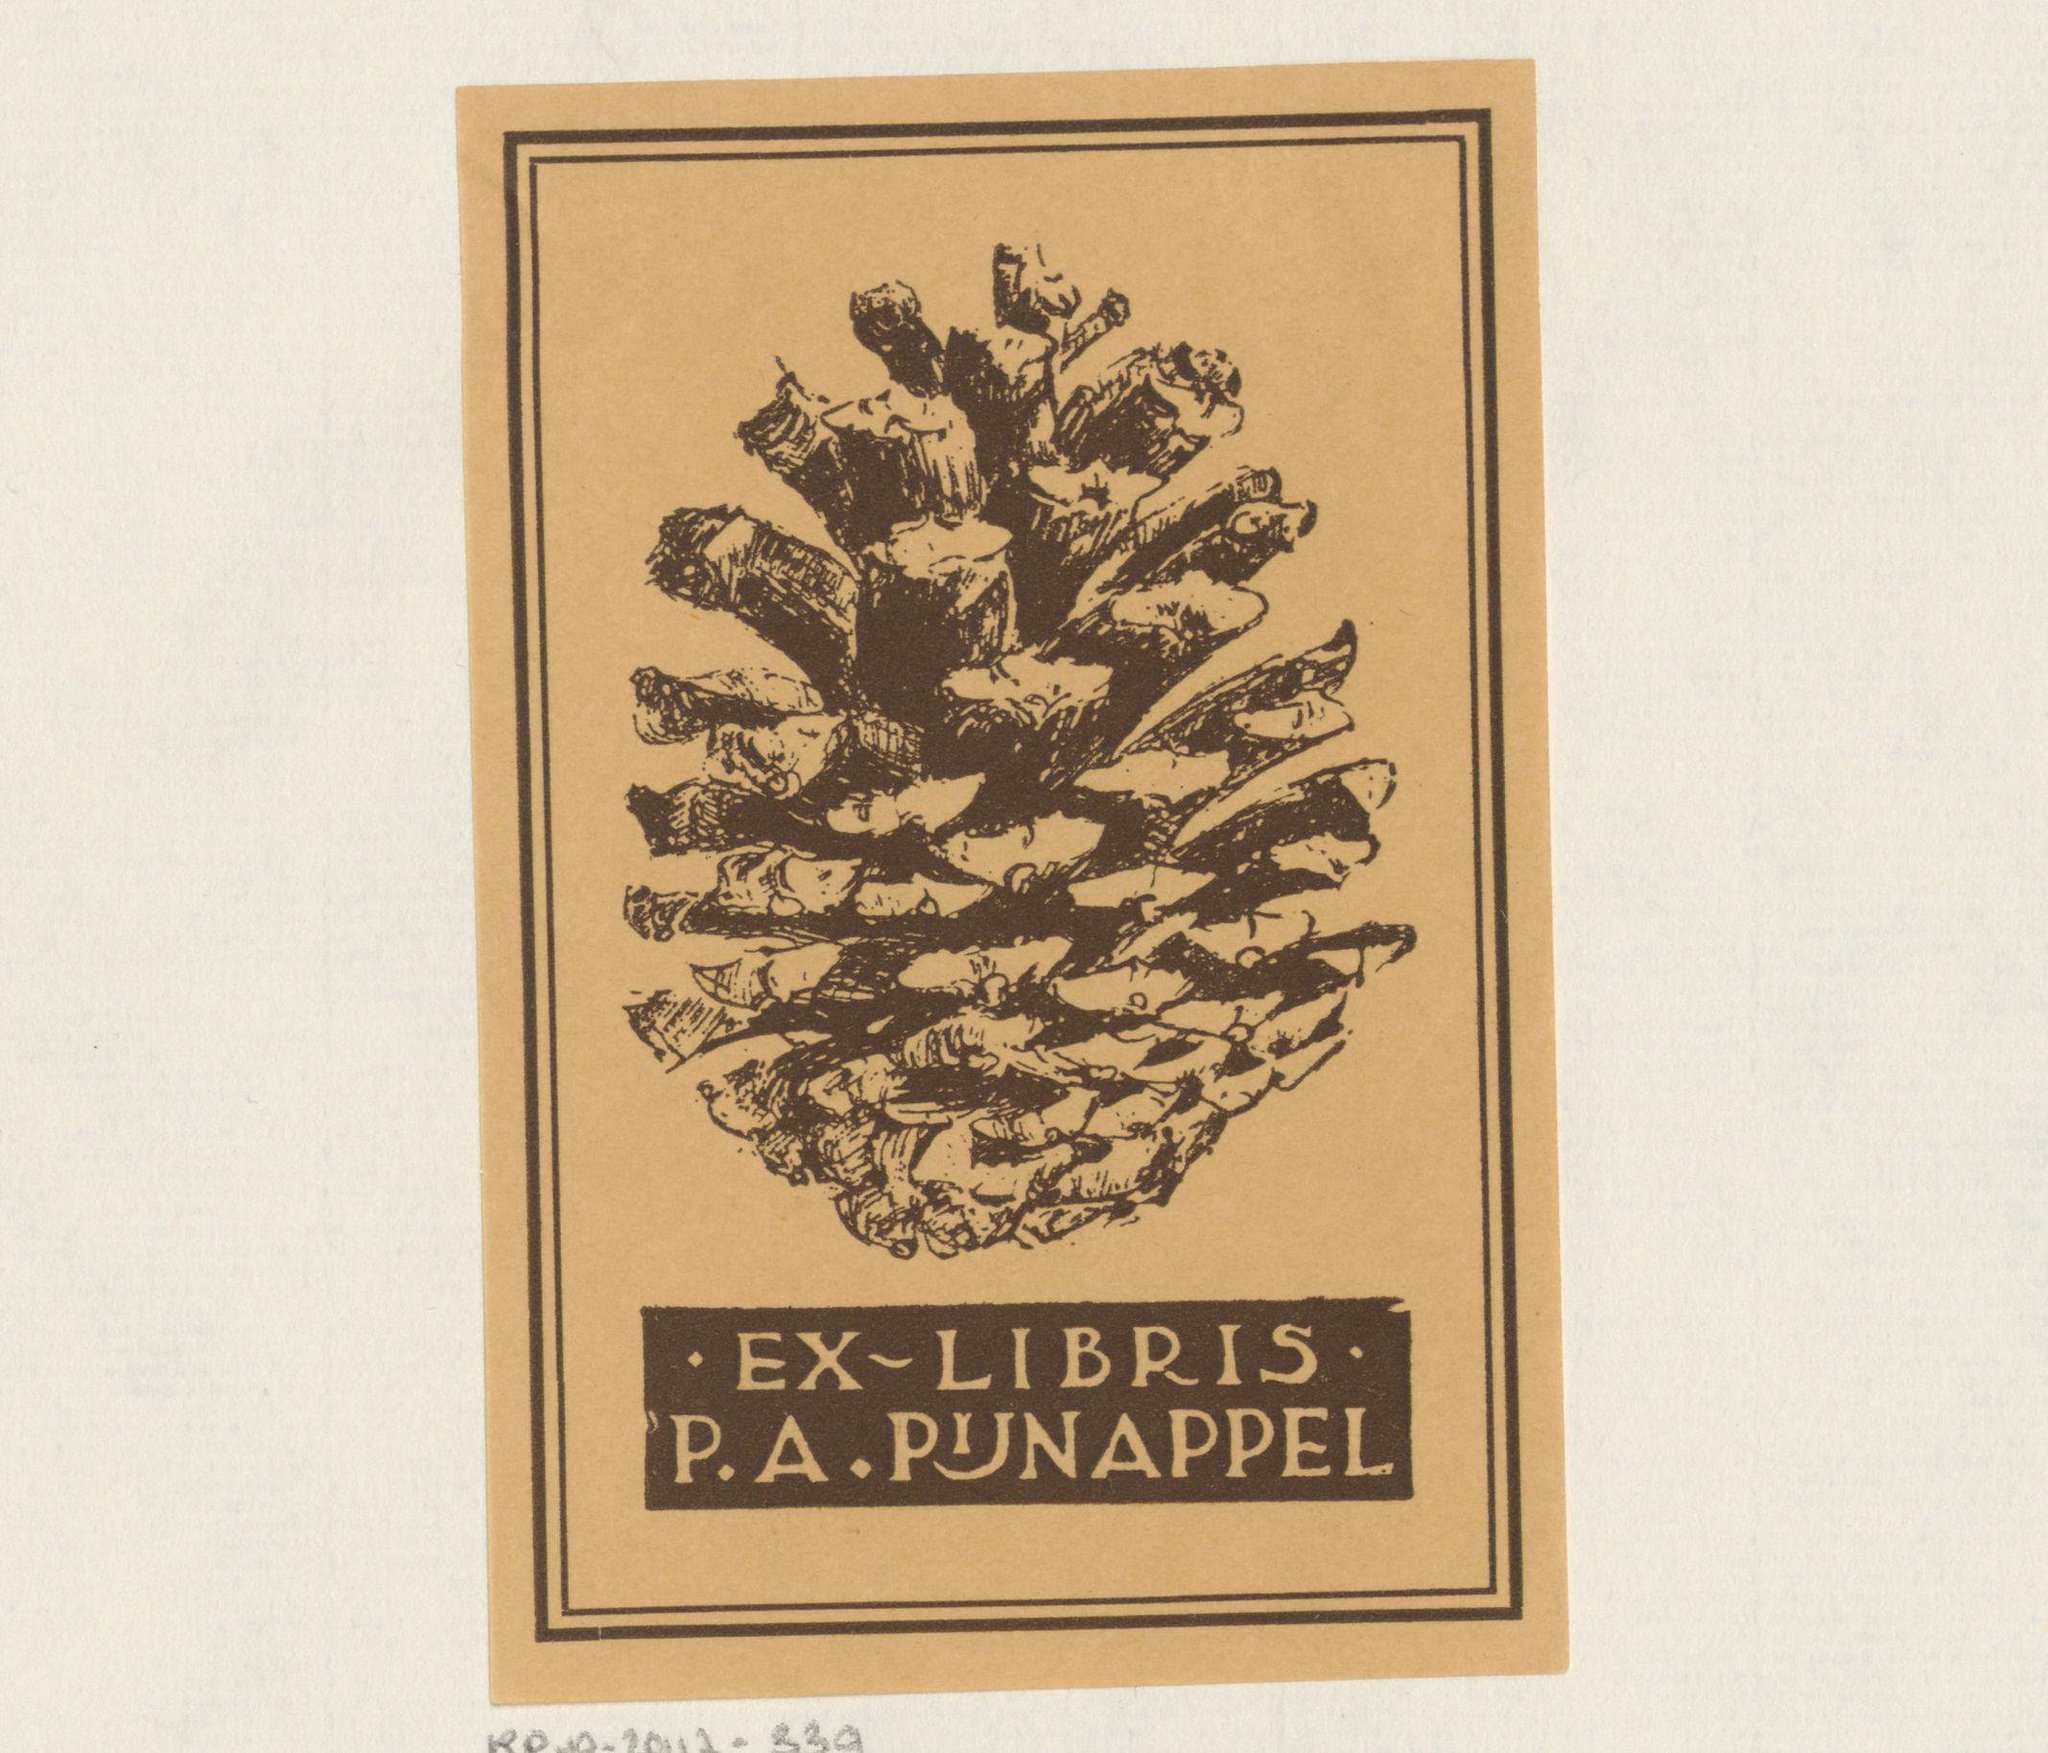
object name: bookplate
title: Ex libris van P.A. Pijnappel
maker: Anonymous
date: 1885-1935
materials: paper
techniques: printing block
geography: netherlands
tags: fruits: pine-cone